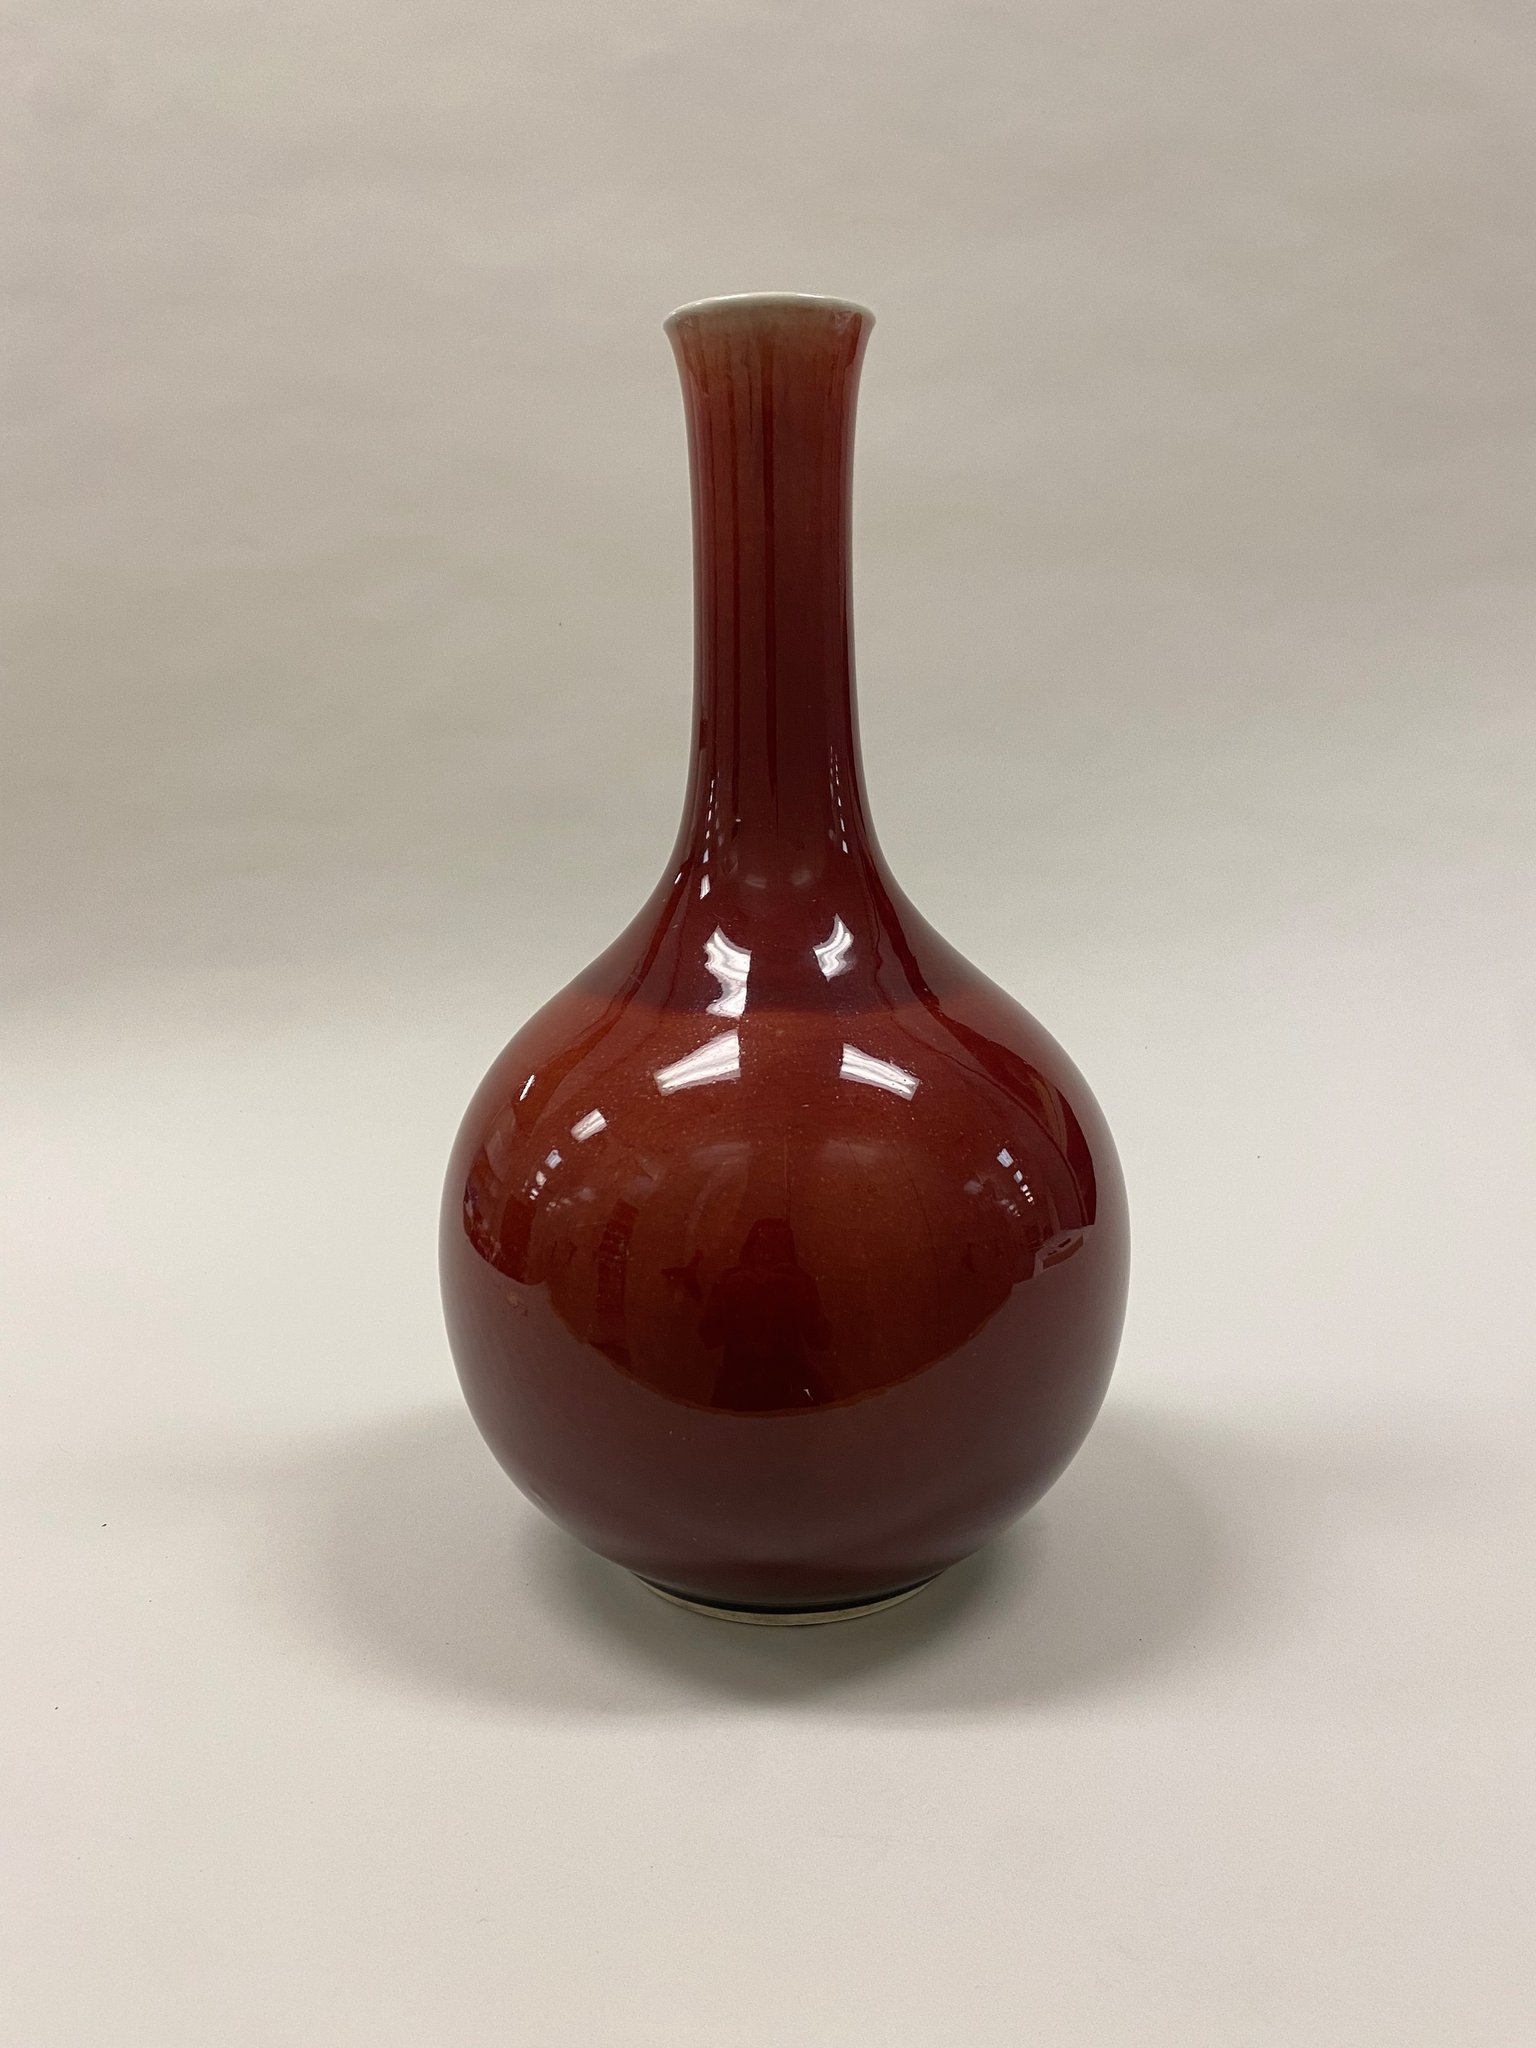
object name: bottle vase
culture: chinese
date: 1667-1733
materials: copper, glaze, porcelain